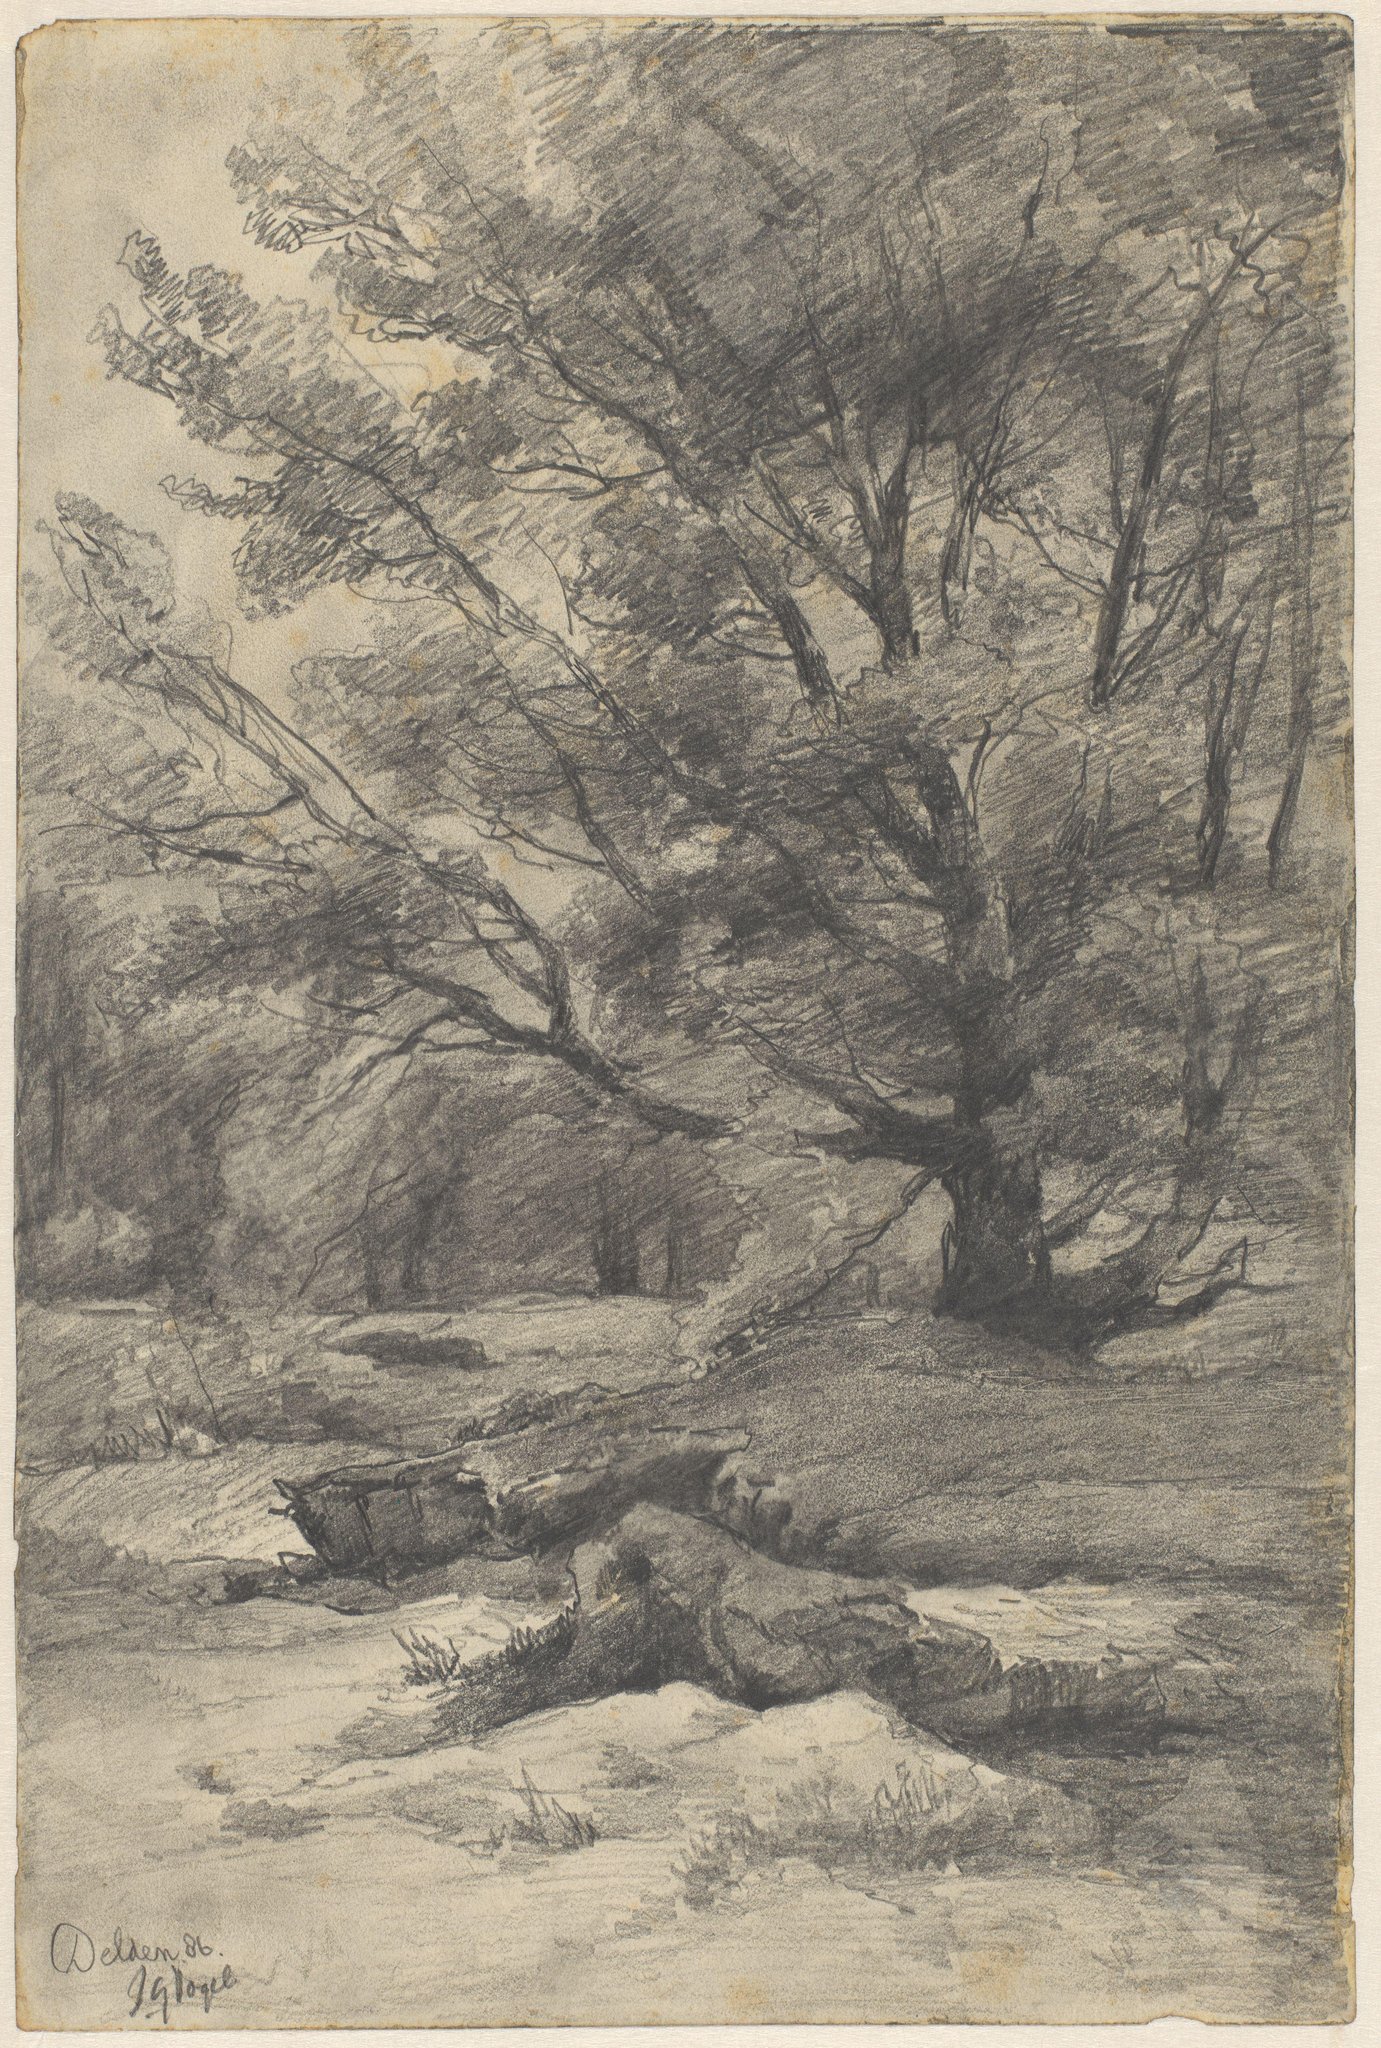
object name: drawing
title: Landschap te Delden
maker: johannes gijsbert vogel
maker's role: draughtsman, painter, print maker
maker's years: 1828-1915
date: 1886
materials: paper, pencil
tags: landscapes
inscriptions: date and inscription: ‘Delden 86’